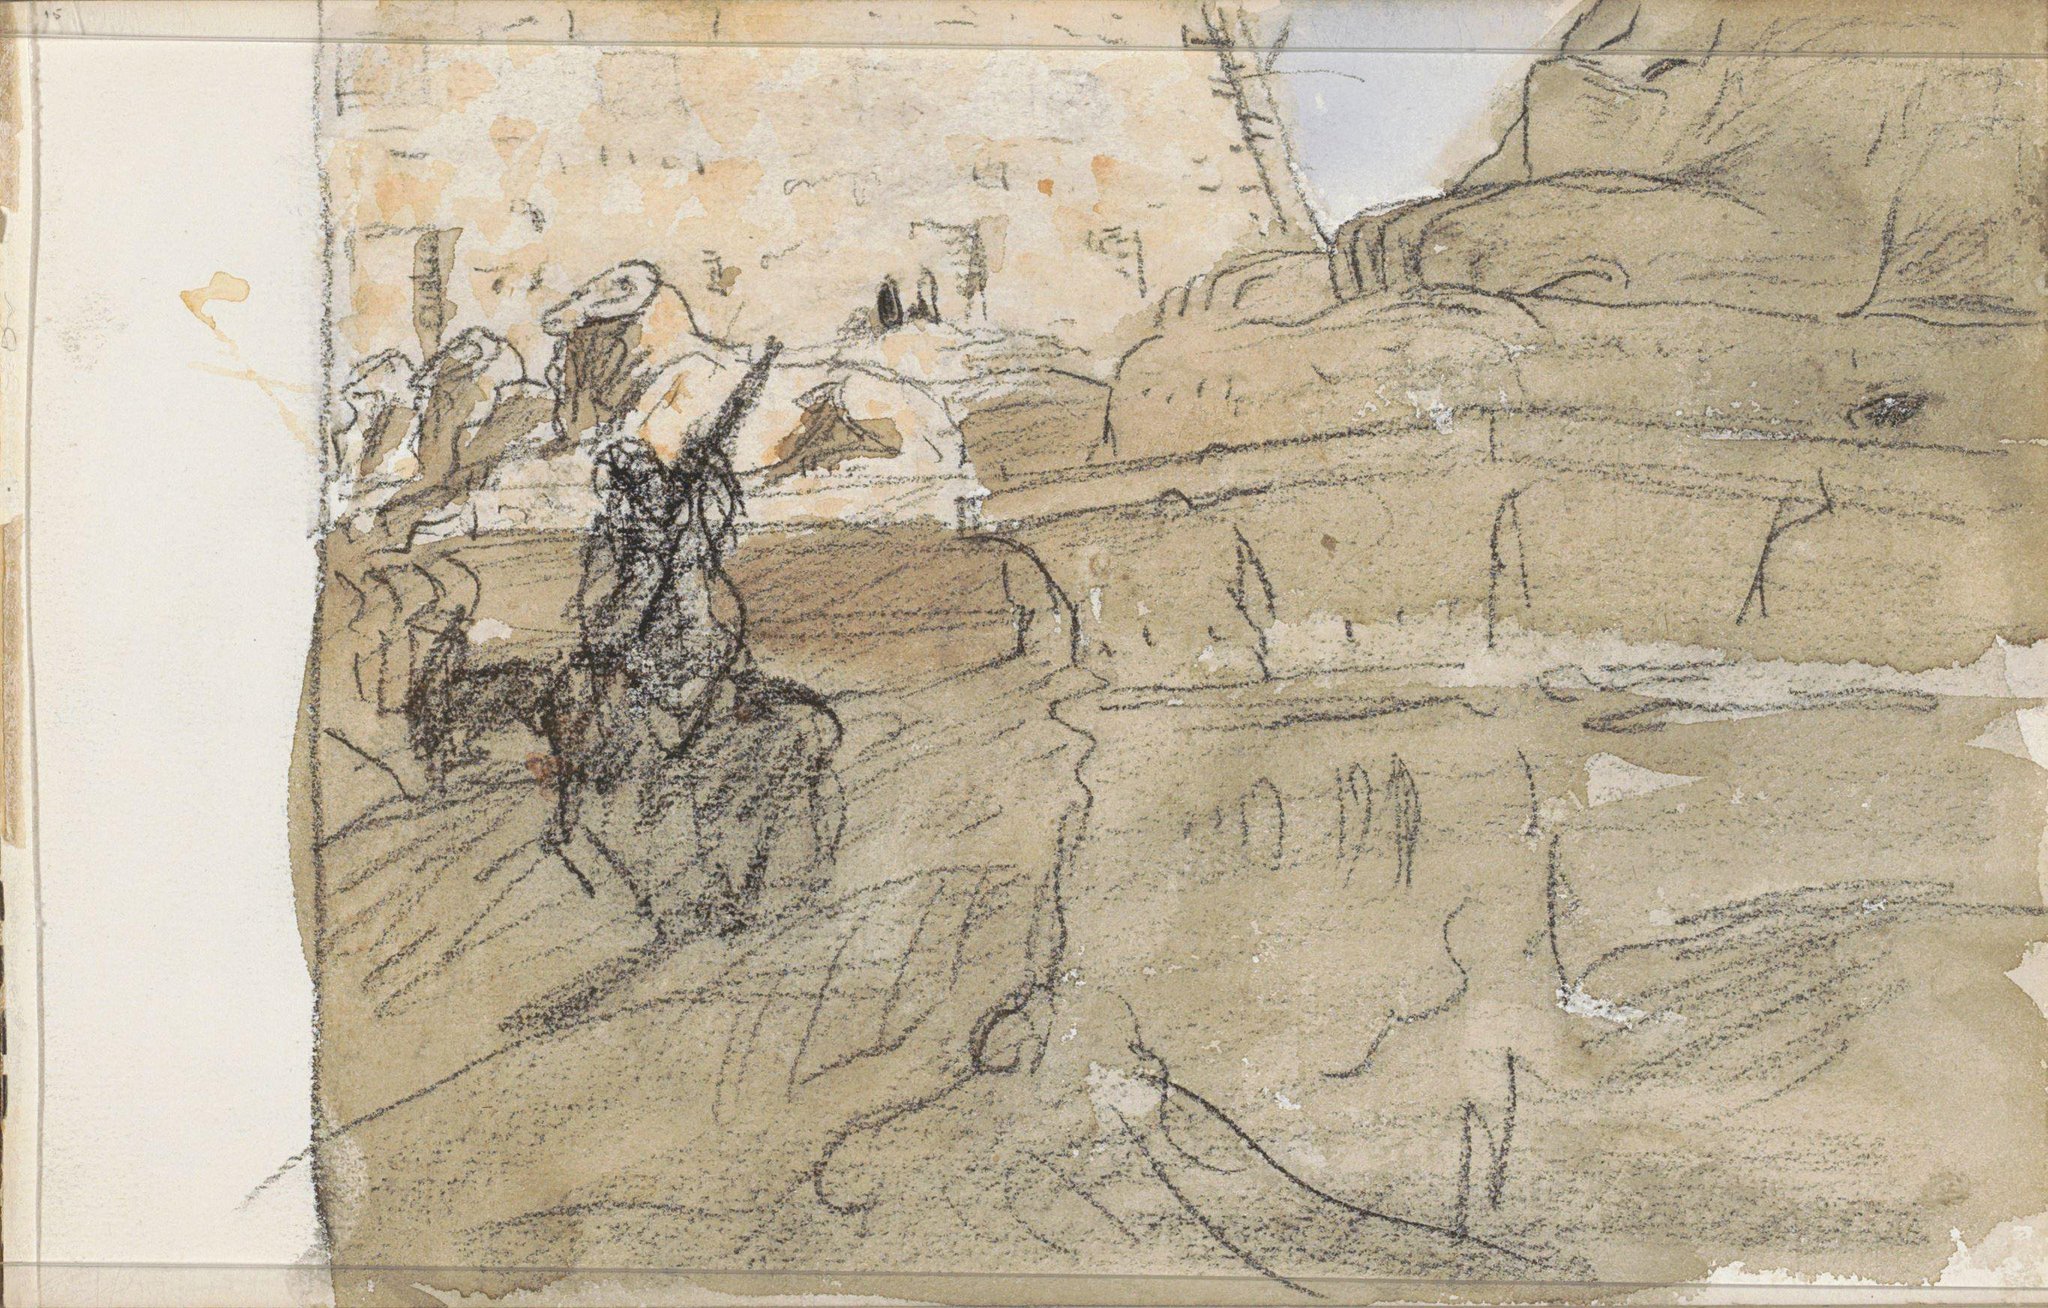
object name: sketchbook leaf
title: Beelden van sfinxen met ramskoppen bij de Tempel van Karnak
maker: marius bauer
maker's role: draughtsman, print maker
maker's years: 1867-1932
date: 1919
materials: chalk, paper, watercolor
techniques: brush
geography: luxor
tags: temple, shrine ~ egyptian religion, sculpture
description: Pagina 15 uit een schetsboek met 18 bladen.